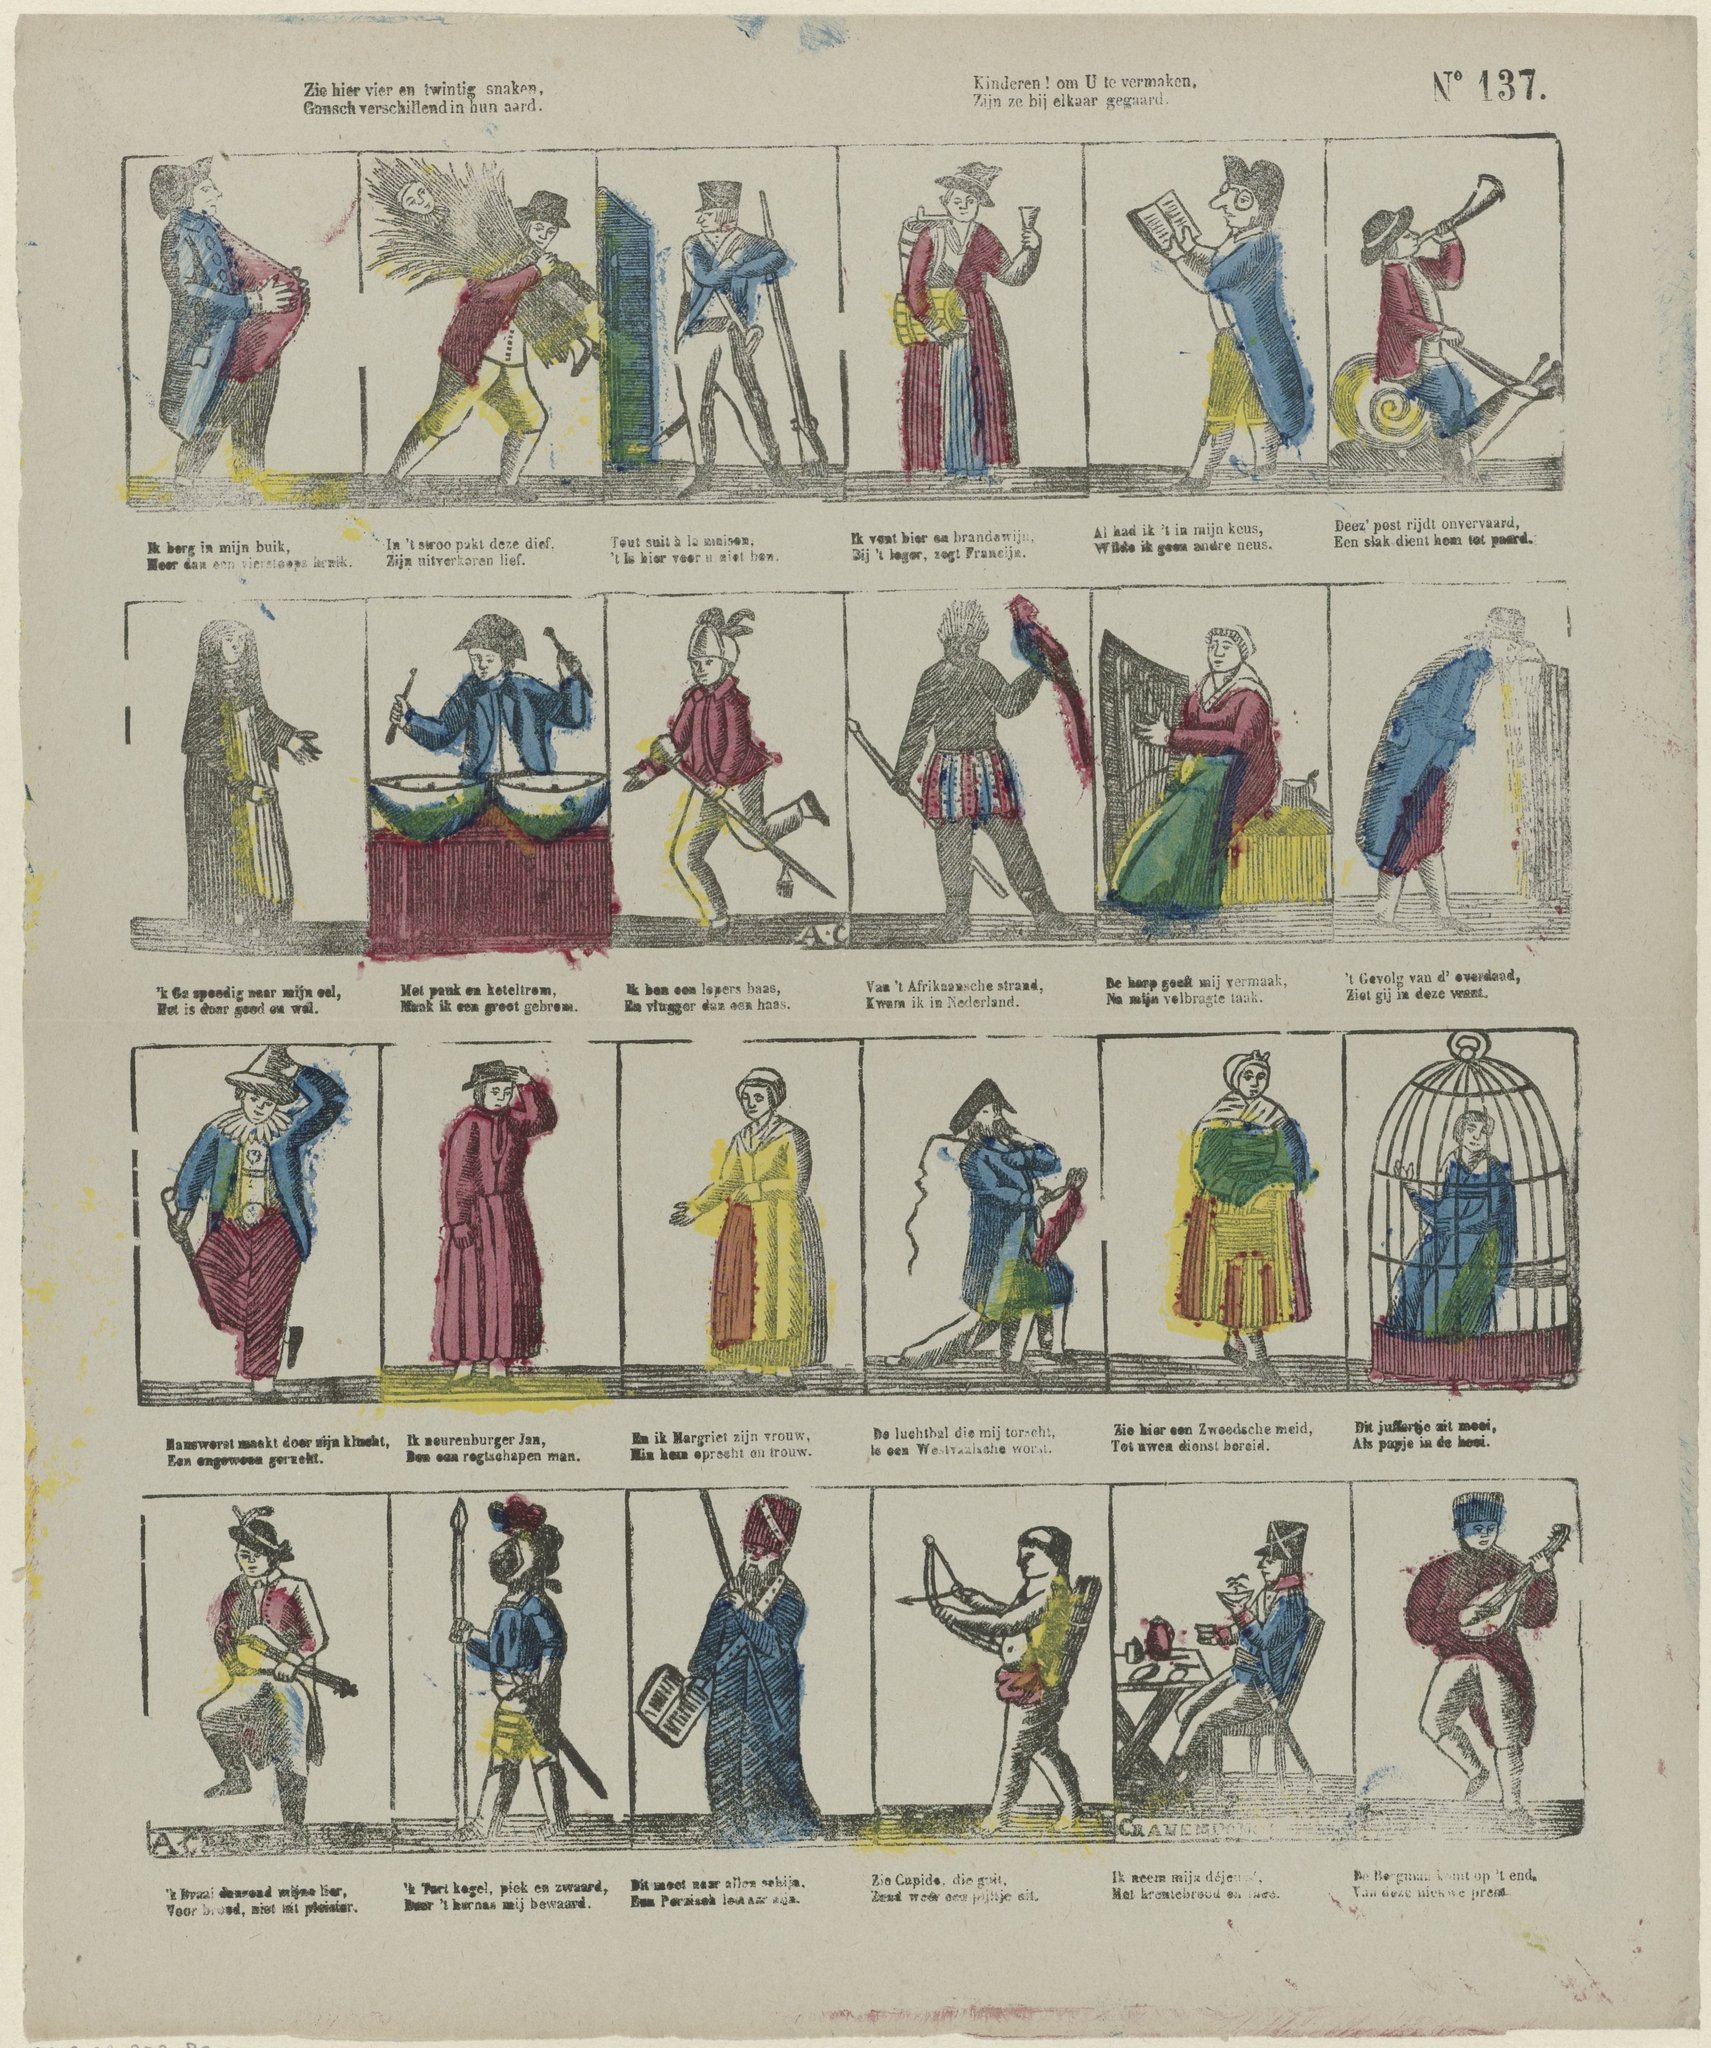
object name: popular print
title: Zie hier vier en twintig snaken, / Gansch verschillend in hun aard / Kinderen! om u te vermaken, / Zijn ze bij elkaar gegaard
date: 1827-1894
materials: paper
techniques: colour, letterpress printing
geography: schaarbeek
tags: caricatures (human types), africans, characters (human types), (story of) cupid, amor (eros)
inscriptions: collector's mark: Lugt 2760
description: Blad met 24 voorstellingen van verschillende figuren, waaronder karikaturale figuren en theaterpersonages. Onder elke afbeelding een tweeregelig vers. Genummerd rechtsboven: No 137.